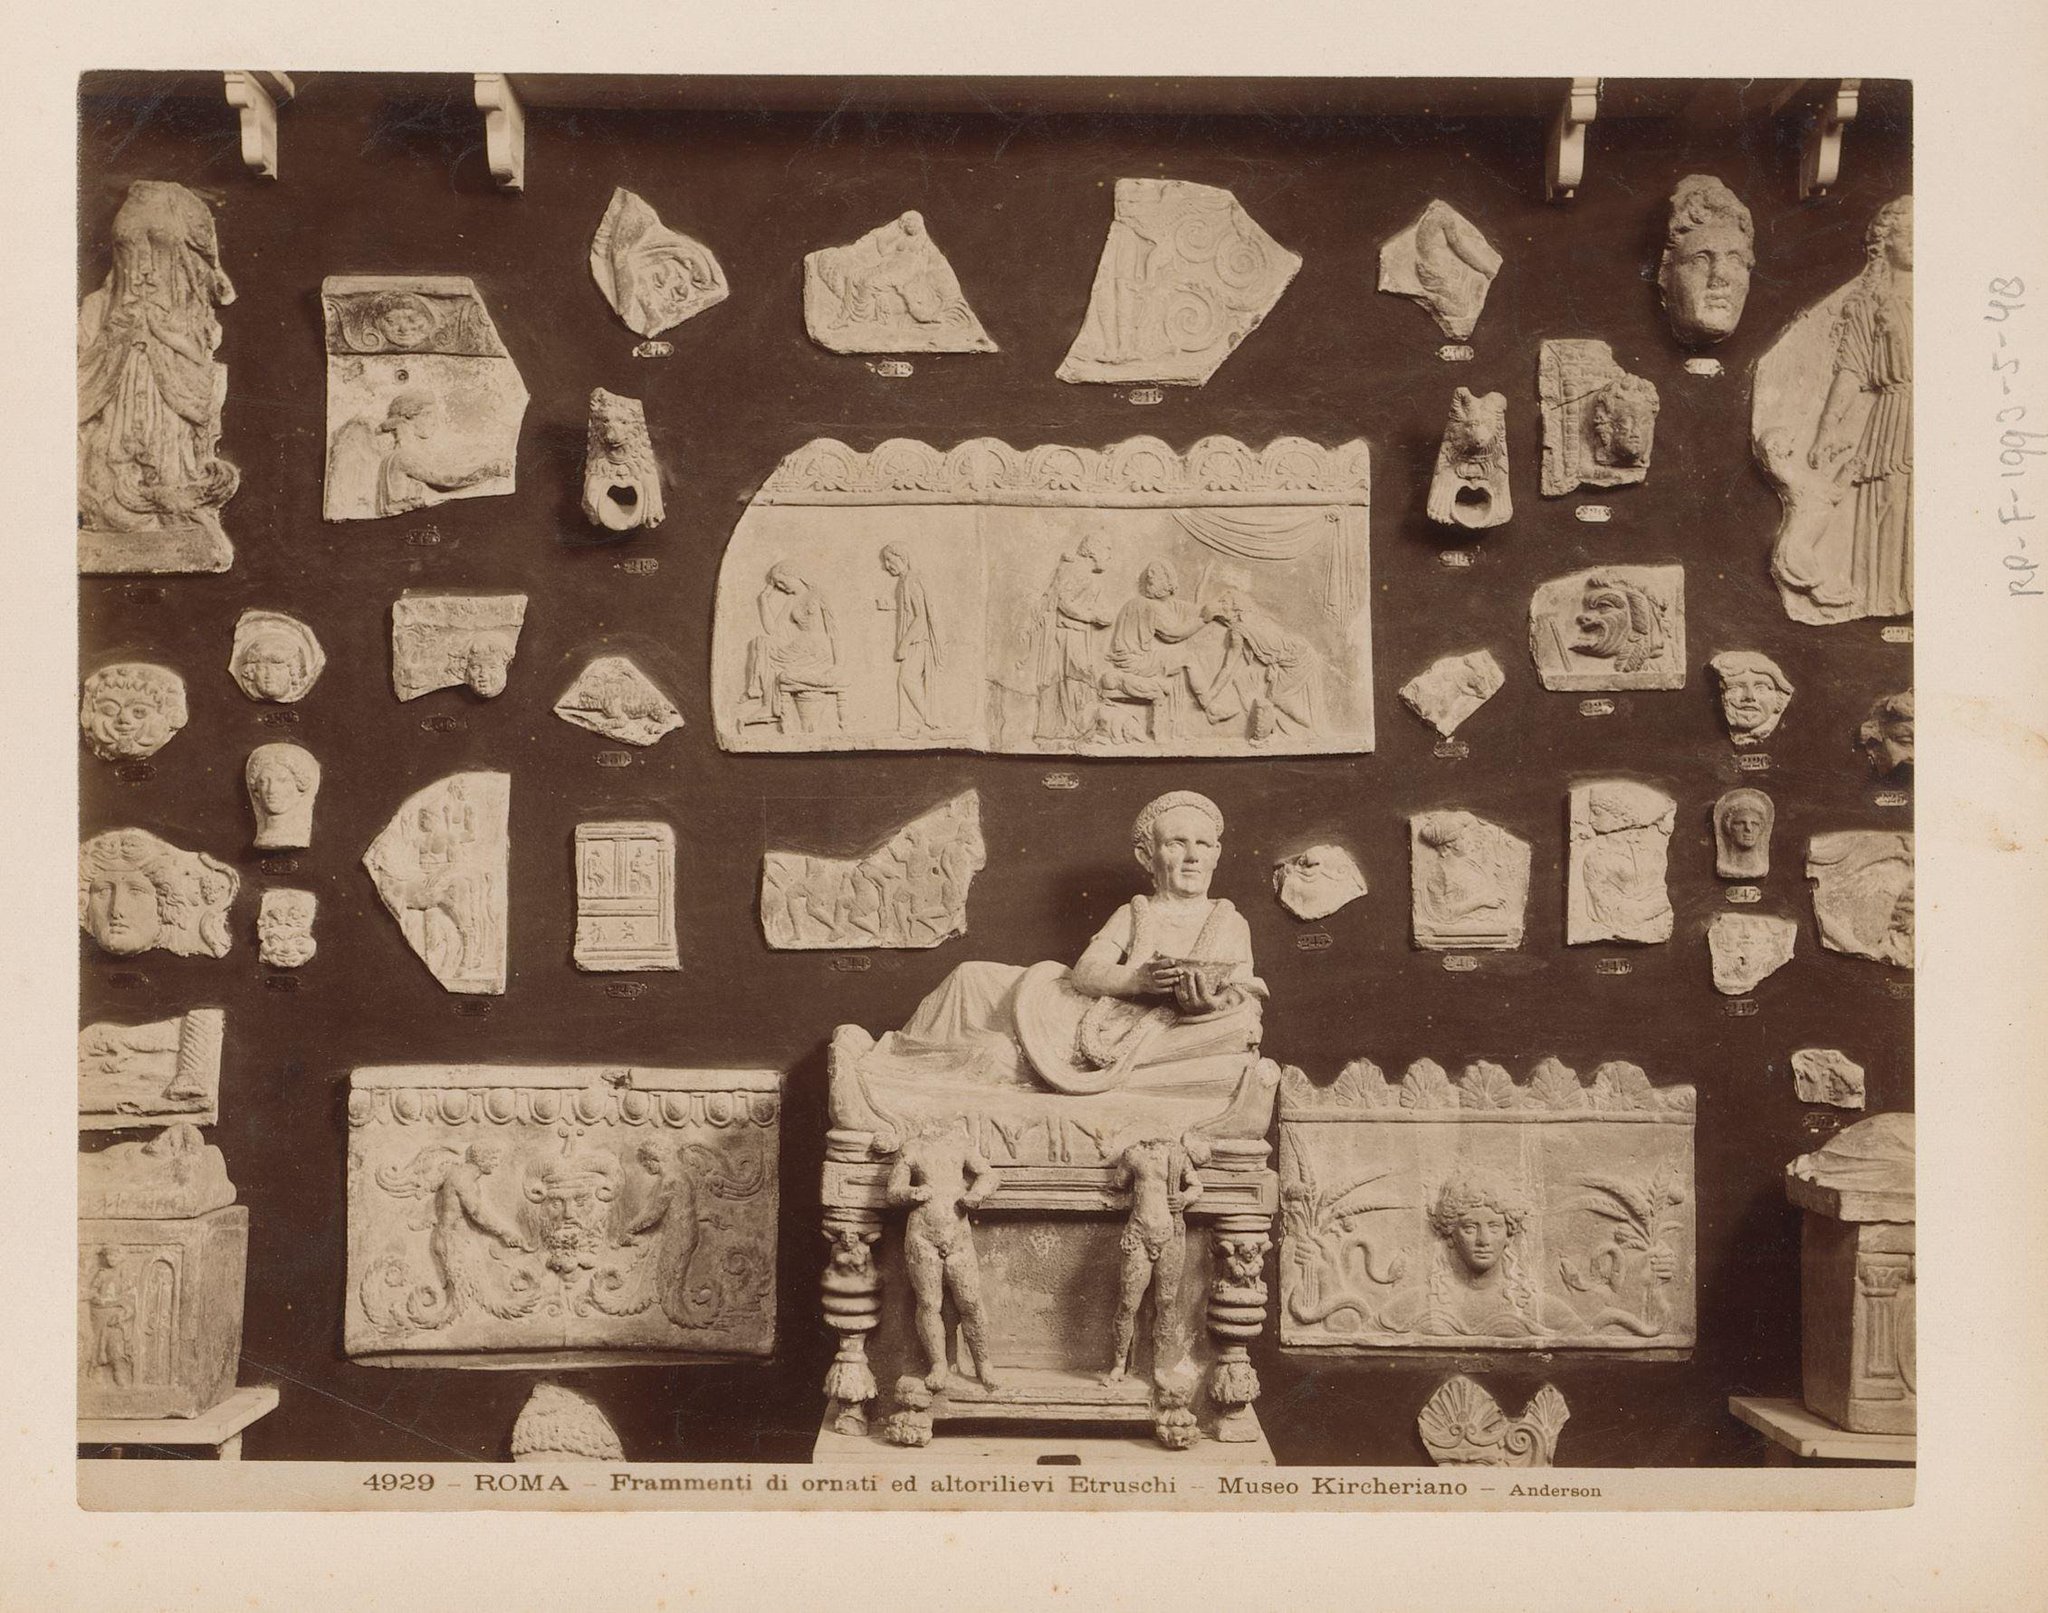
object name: album leaf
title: Fragmenten van Etruskische ornamenten en reliëfs in het Museo Kircheriano te Rome, Italië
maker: james anderson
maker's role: fotograaf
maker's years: 1813-1877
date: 1857-1875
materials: paper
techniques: albumen print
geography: rome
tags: ornaments ~ art, piece of sculpture, reproduction of a piece of sculpture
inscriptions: number: ‘4929’